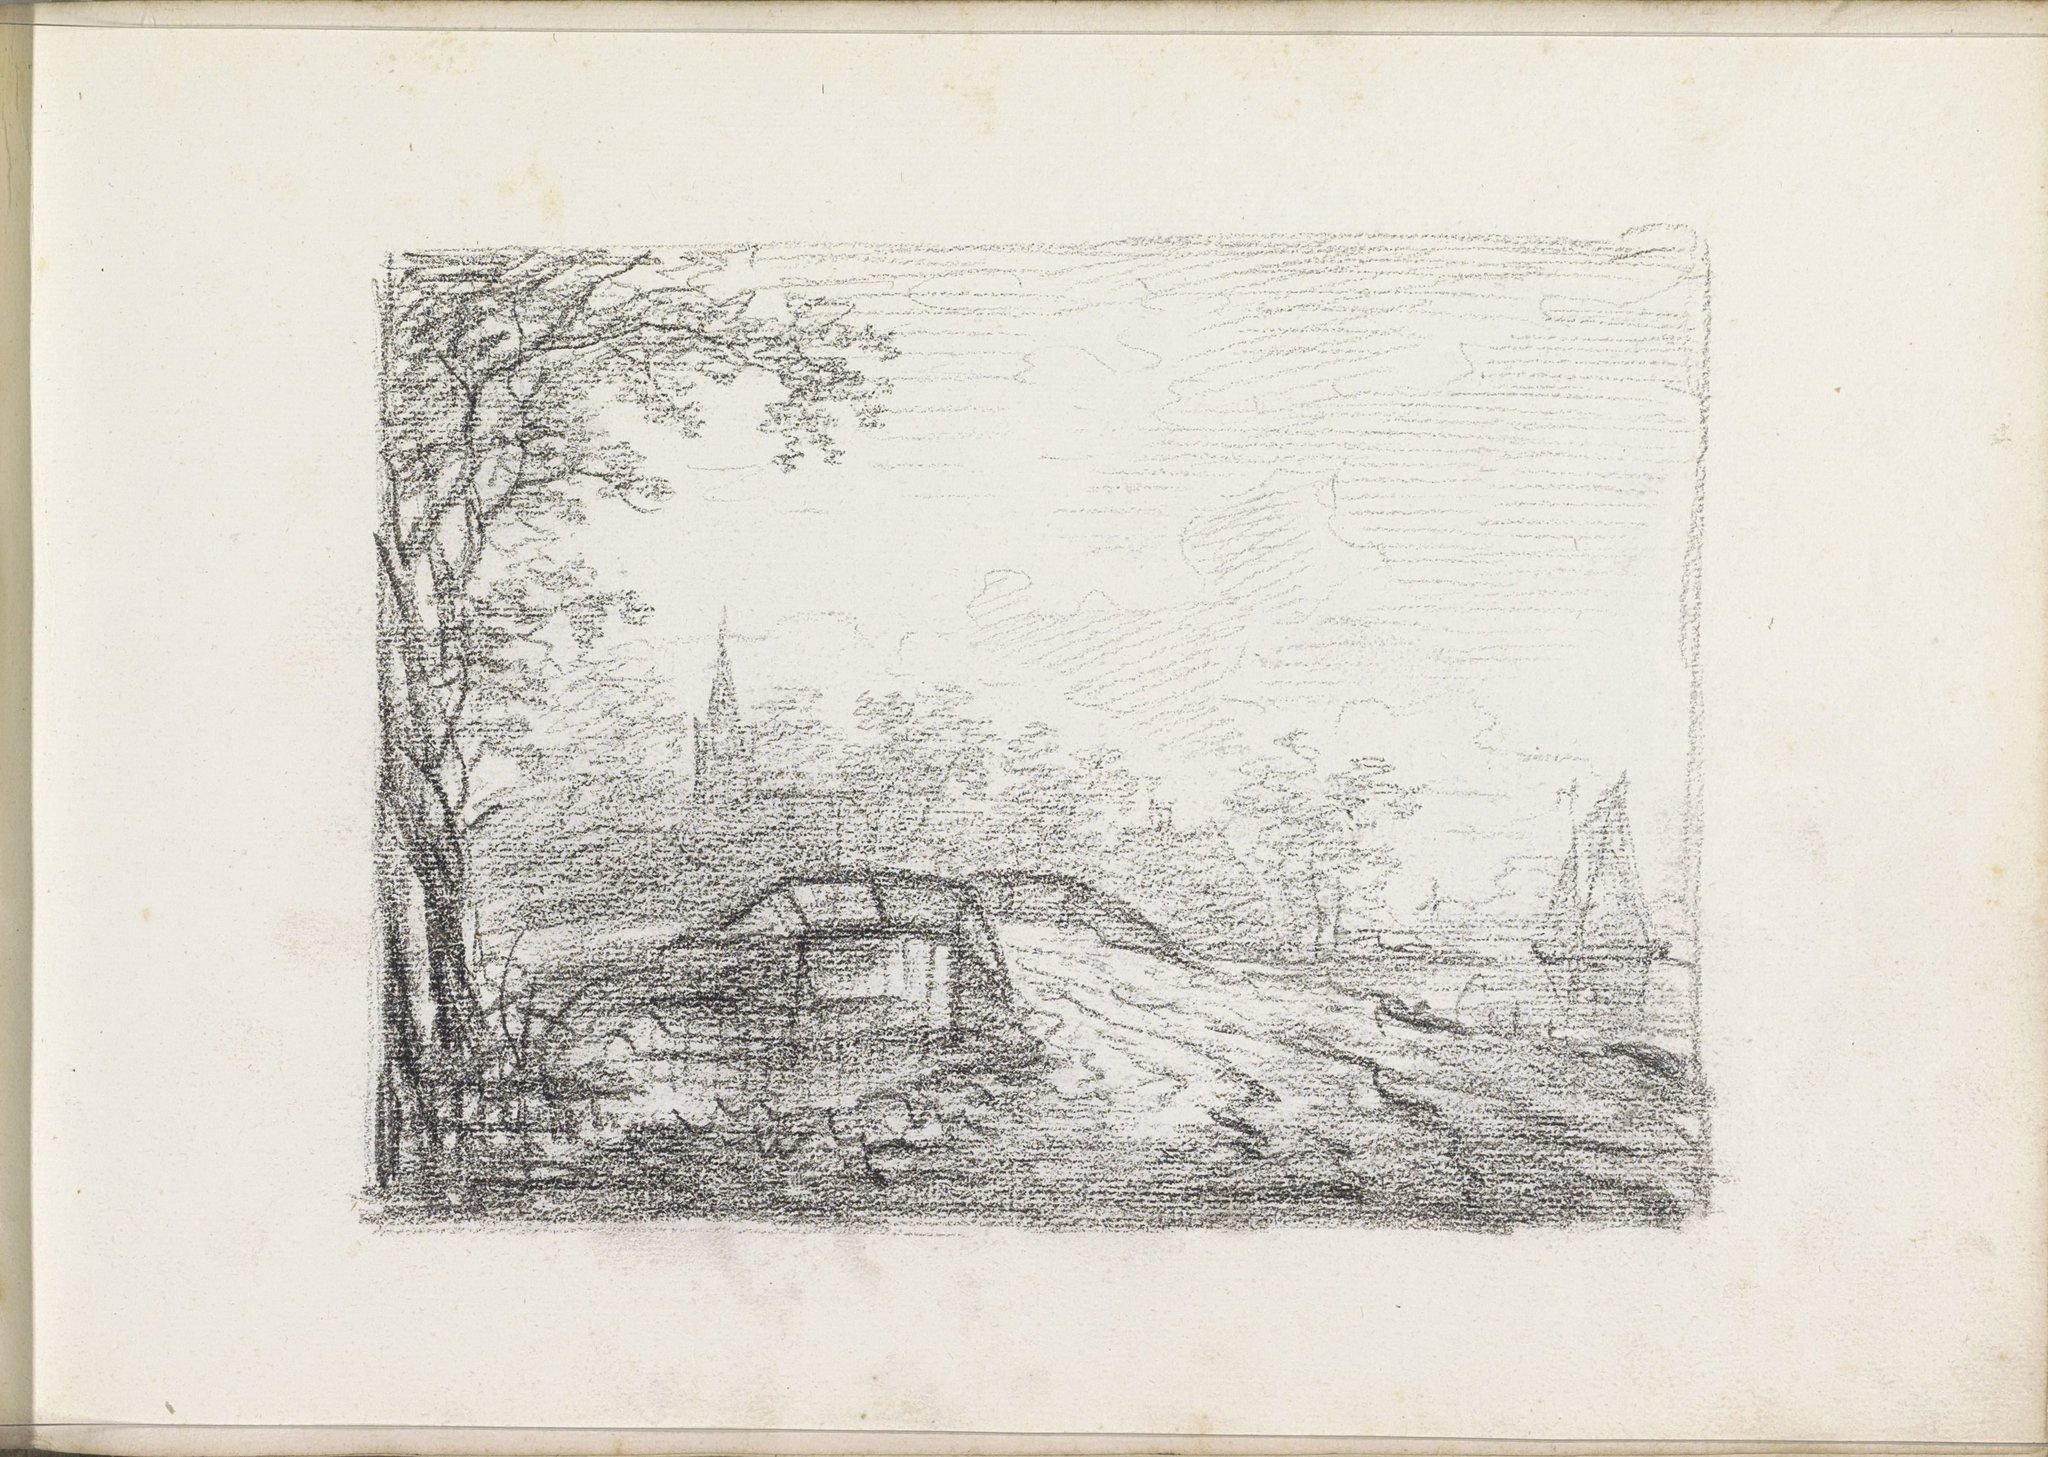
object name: sketchbook leaf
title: Landschap met een kerk, zeilschip en brug over een rivier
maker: andreas schelfhout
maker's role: draughtsman, painter, print maker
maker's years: 1787-1870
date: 1811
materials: chalk, paper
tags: prospect of village, silhouette of village, landscapes with waters, waterscapes, seascapes (in the temperate zone), bridge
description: Blad 13 recto uit een schetsboek met 75 bladen.